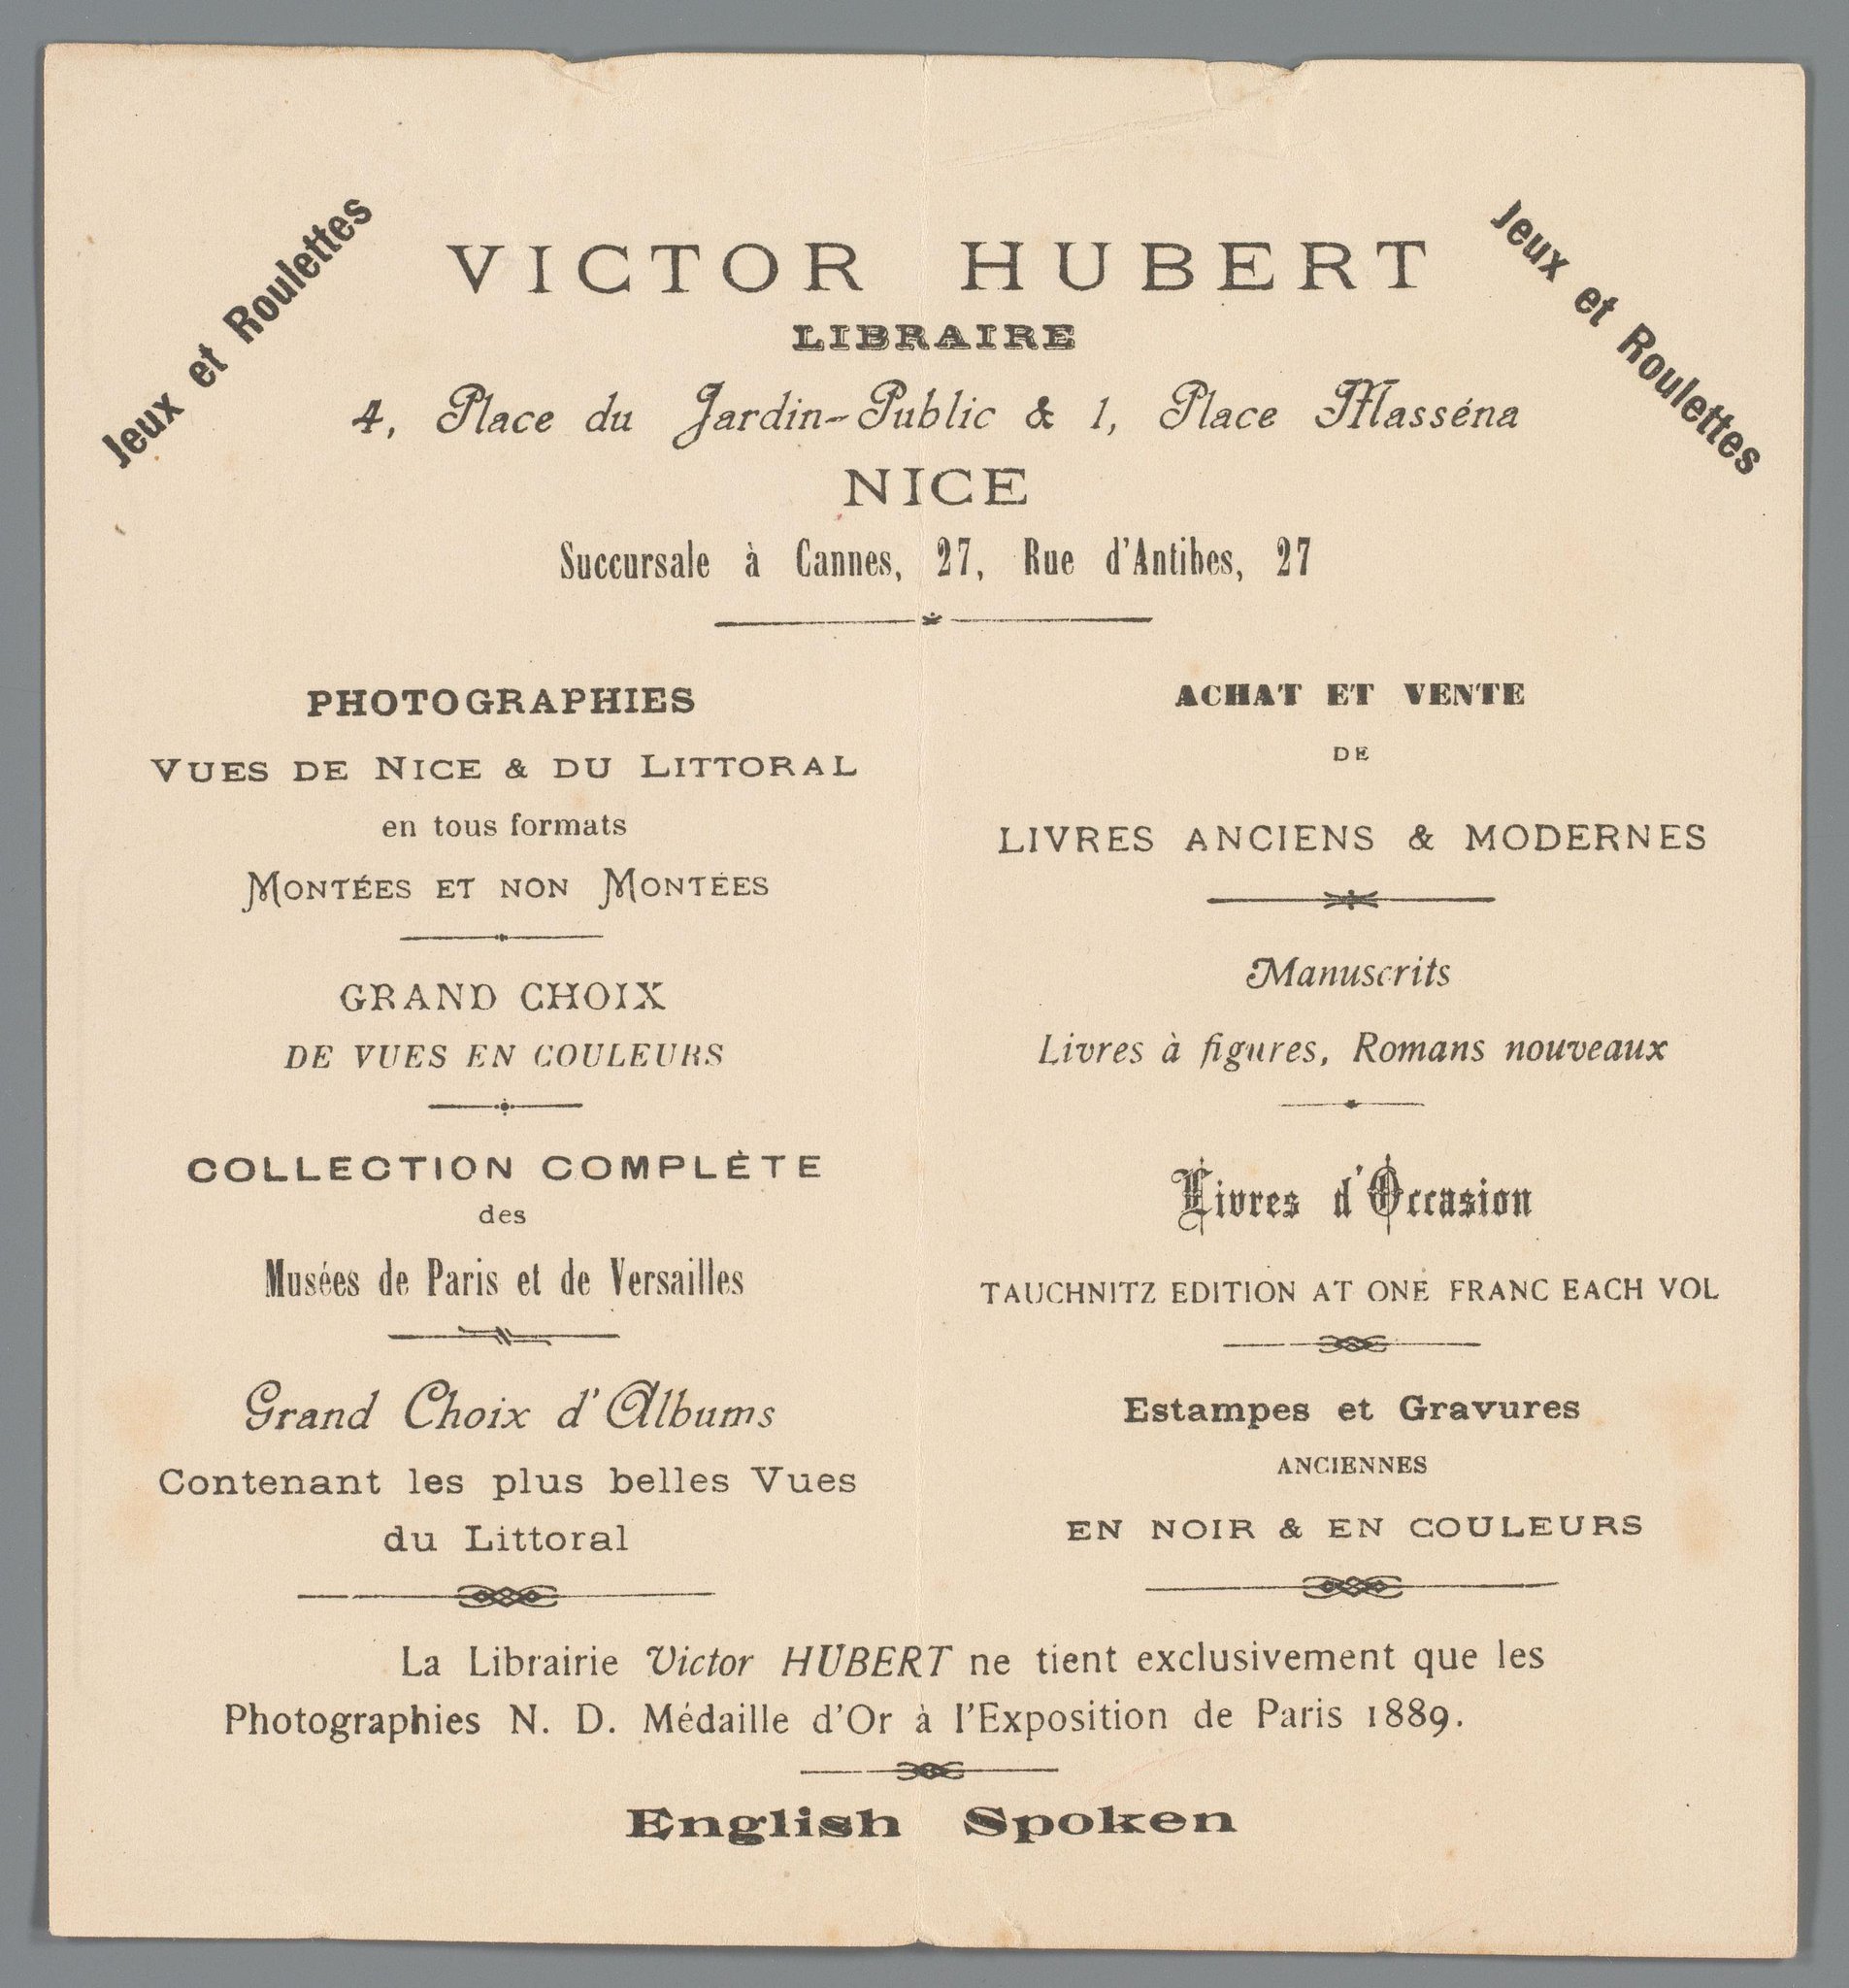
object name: folder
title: Strooibiljet van fotoverkoper Victor Hubert uit Nice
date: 1890-1900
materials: paper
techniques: printing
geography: nice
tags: printed matter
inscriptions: inscription: ‘Roulette de Monaco / [...] / IMP. GANDINI, NICE’, inscription: ‘[...] / VICTOR HUBERT / LIBRAIRE / 4, Place du Jardin-Public & 1, Place Masséna / NICE / Succursale à Cannes, 27, Rue d'Antibes, 27 / PHOTOGRAPHIES / VUES DE NICE & DU LITTORAL / en tous formats / MONTÉES ET NON MONTÉES / GRAND CHOIX / DE VUES EN COULEURS / COLLECTION COMPLÈTE / des / Musées de Paris et de Versailles / Grand Choix d'Albums / Contenant les plus belles Vues / du Littoral / [...] / La Librairie Victor Hubert ne tient exclusivement que les / Photographies N. D. [= Neurdein Frères] Médaille d'Or à l'Exposition de Paris 1889. / English Spoken’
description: Strooibiljet van de fotoverkoper Victor Hubert uit Nice, met op de achterzijde reclame voor de "Roulette de Monaco".